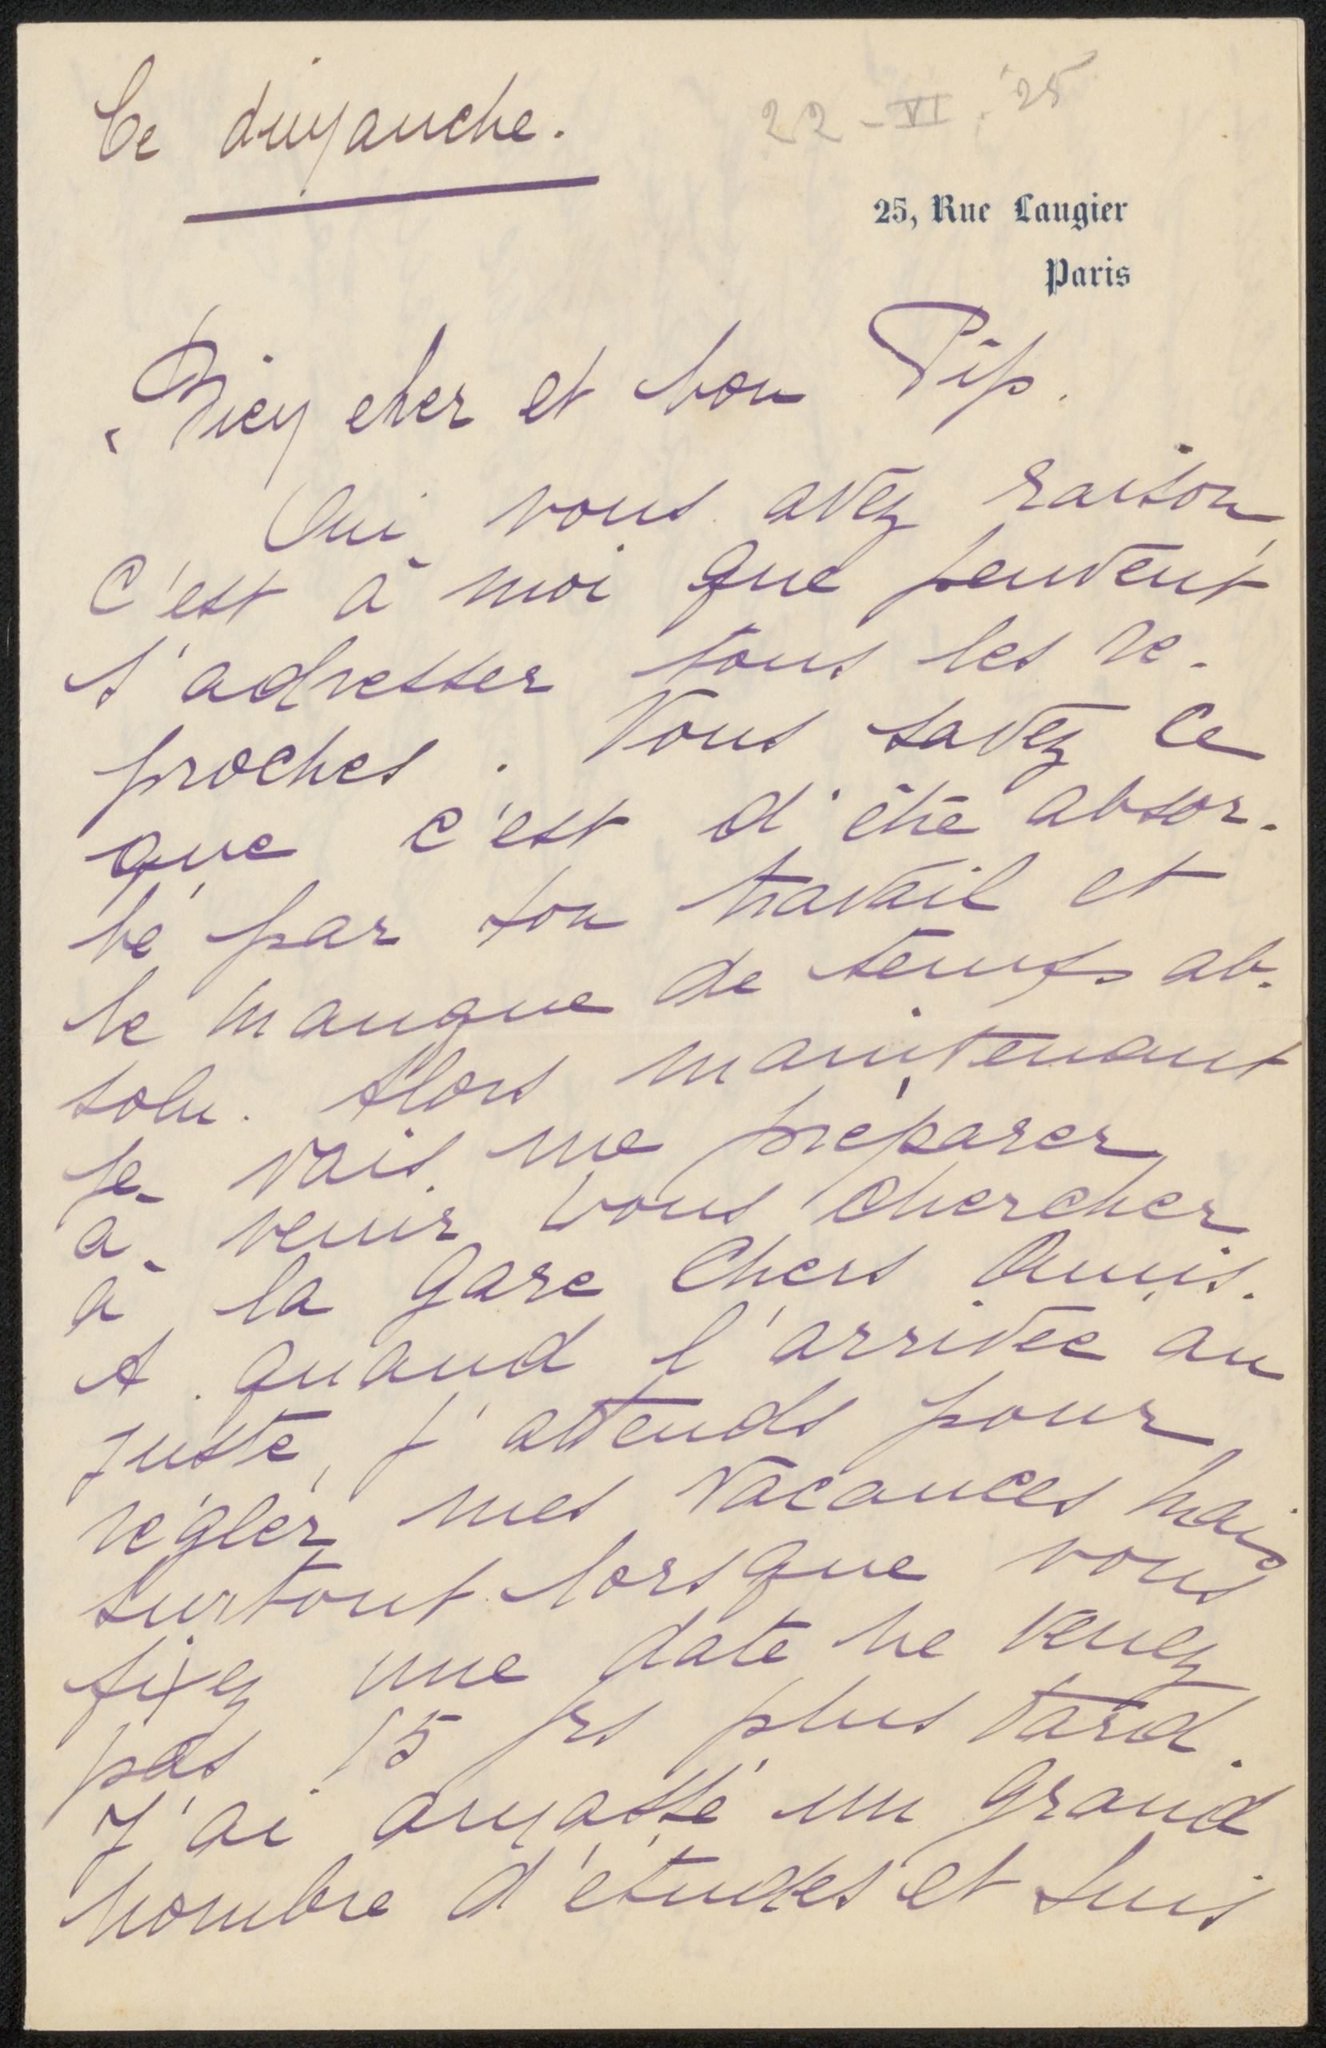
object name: letter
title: Brief aan Philip Zilcken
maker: rose imel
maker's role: draughtsman, painter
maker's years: 1901-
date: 1911-1930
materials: ink, paper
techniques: pen, printing, writing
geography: paris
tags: middelburg, paris, print maker, isodoor boasson, the hague, philip zilcken, printed matter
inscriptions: collector's mark: ‘RPK’